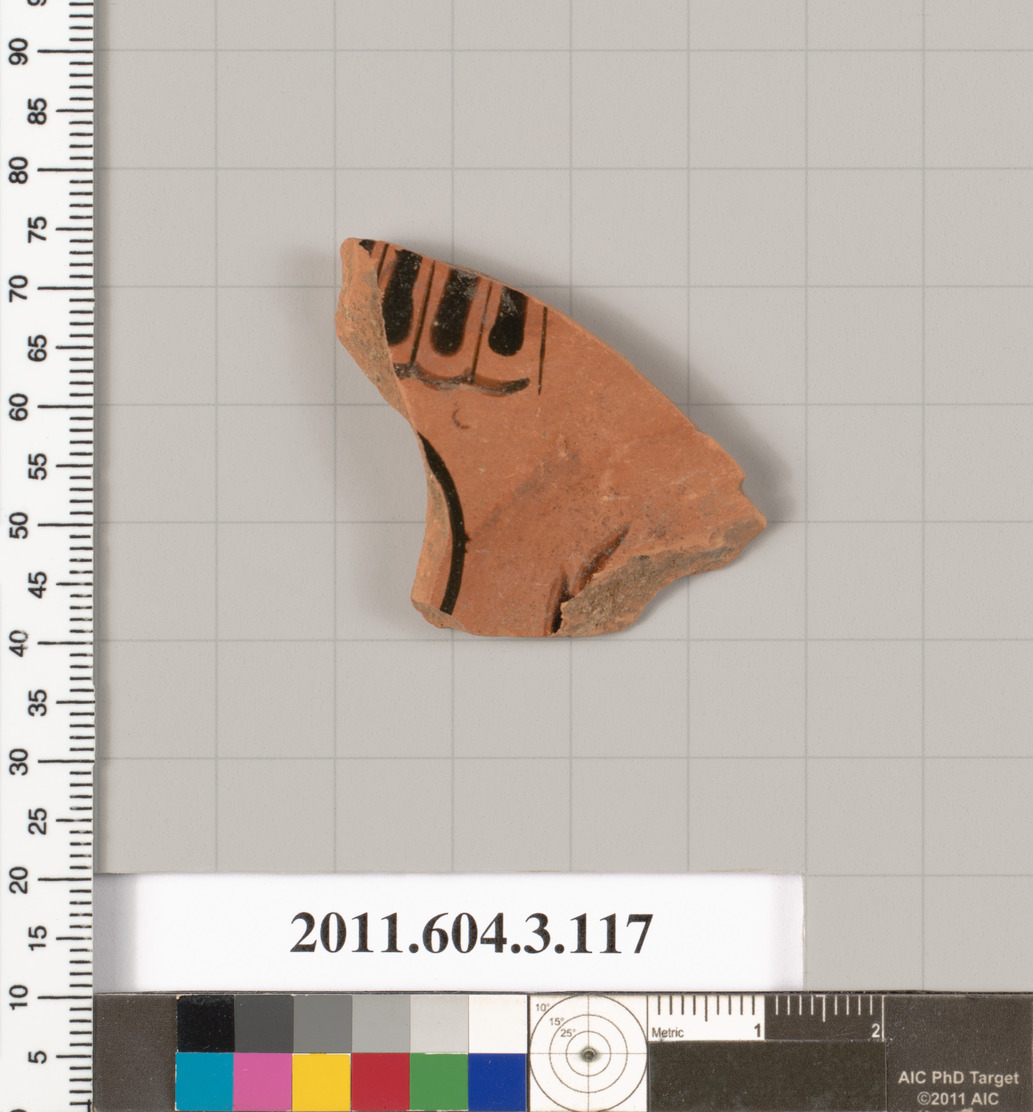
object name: amphora fragment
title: Terracotta fragment of an amphora (jar)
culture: greek, attic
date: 510-500 BCE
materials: terracotta